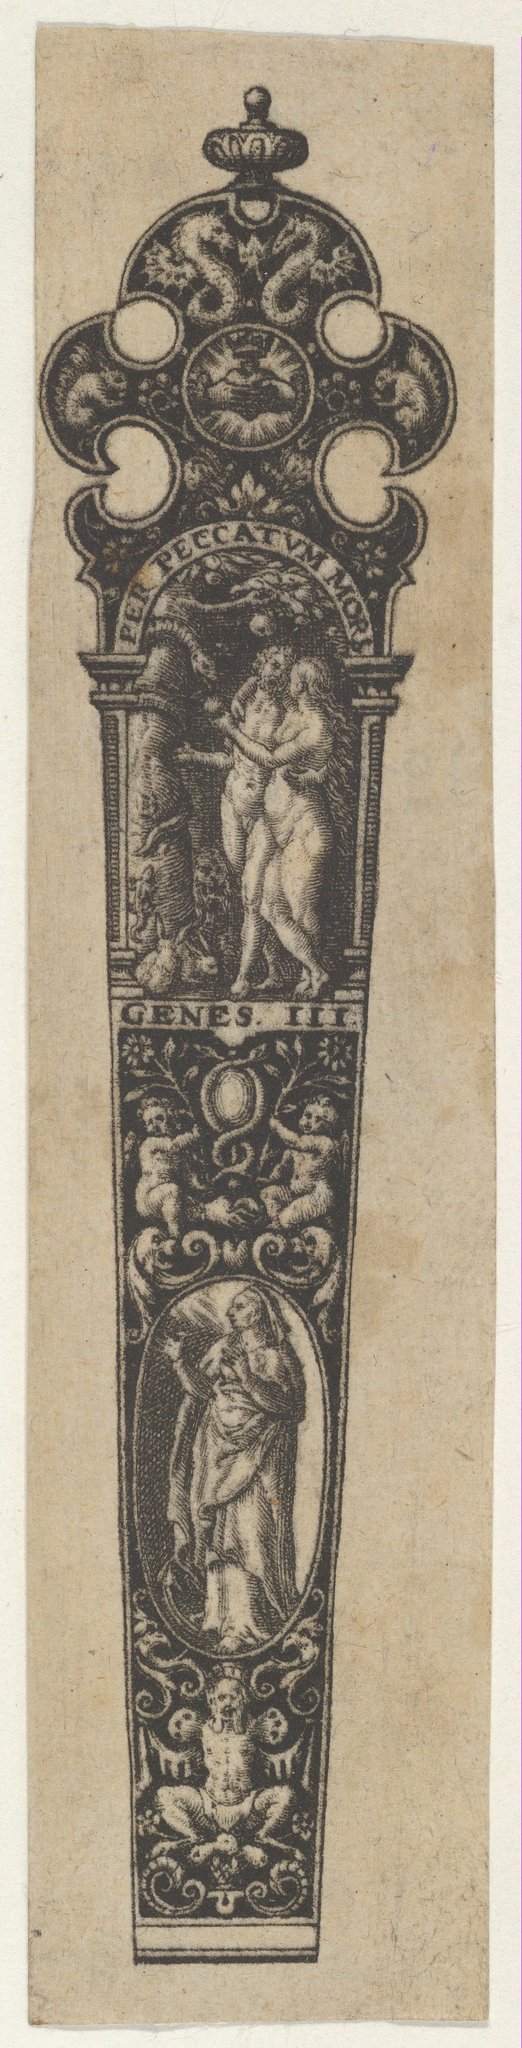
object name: print ornament architecture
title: Design for a Knife Handle with the Temptation of Adam and Eve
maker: johann theodor de bry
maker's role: artist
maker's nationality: netherlandish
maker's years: 1561-1623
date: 1580-1600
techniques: embroidery, engraving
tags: adam,eve